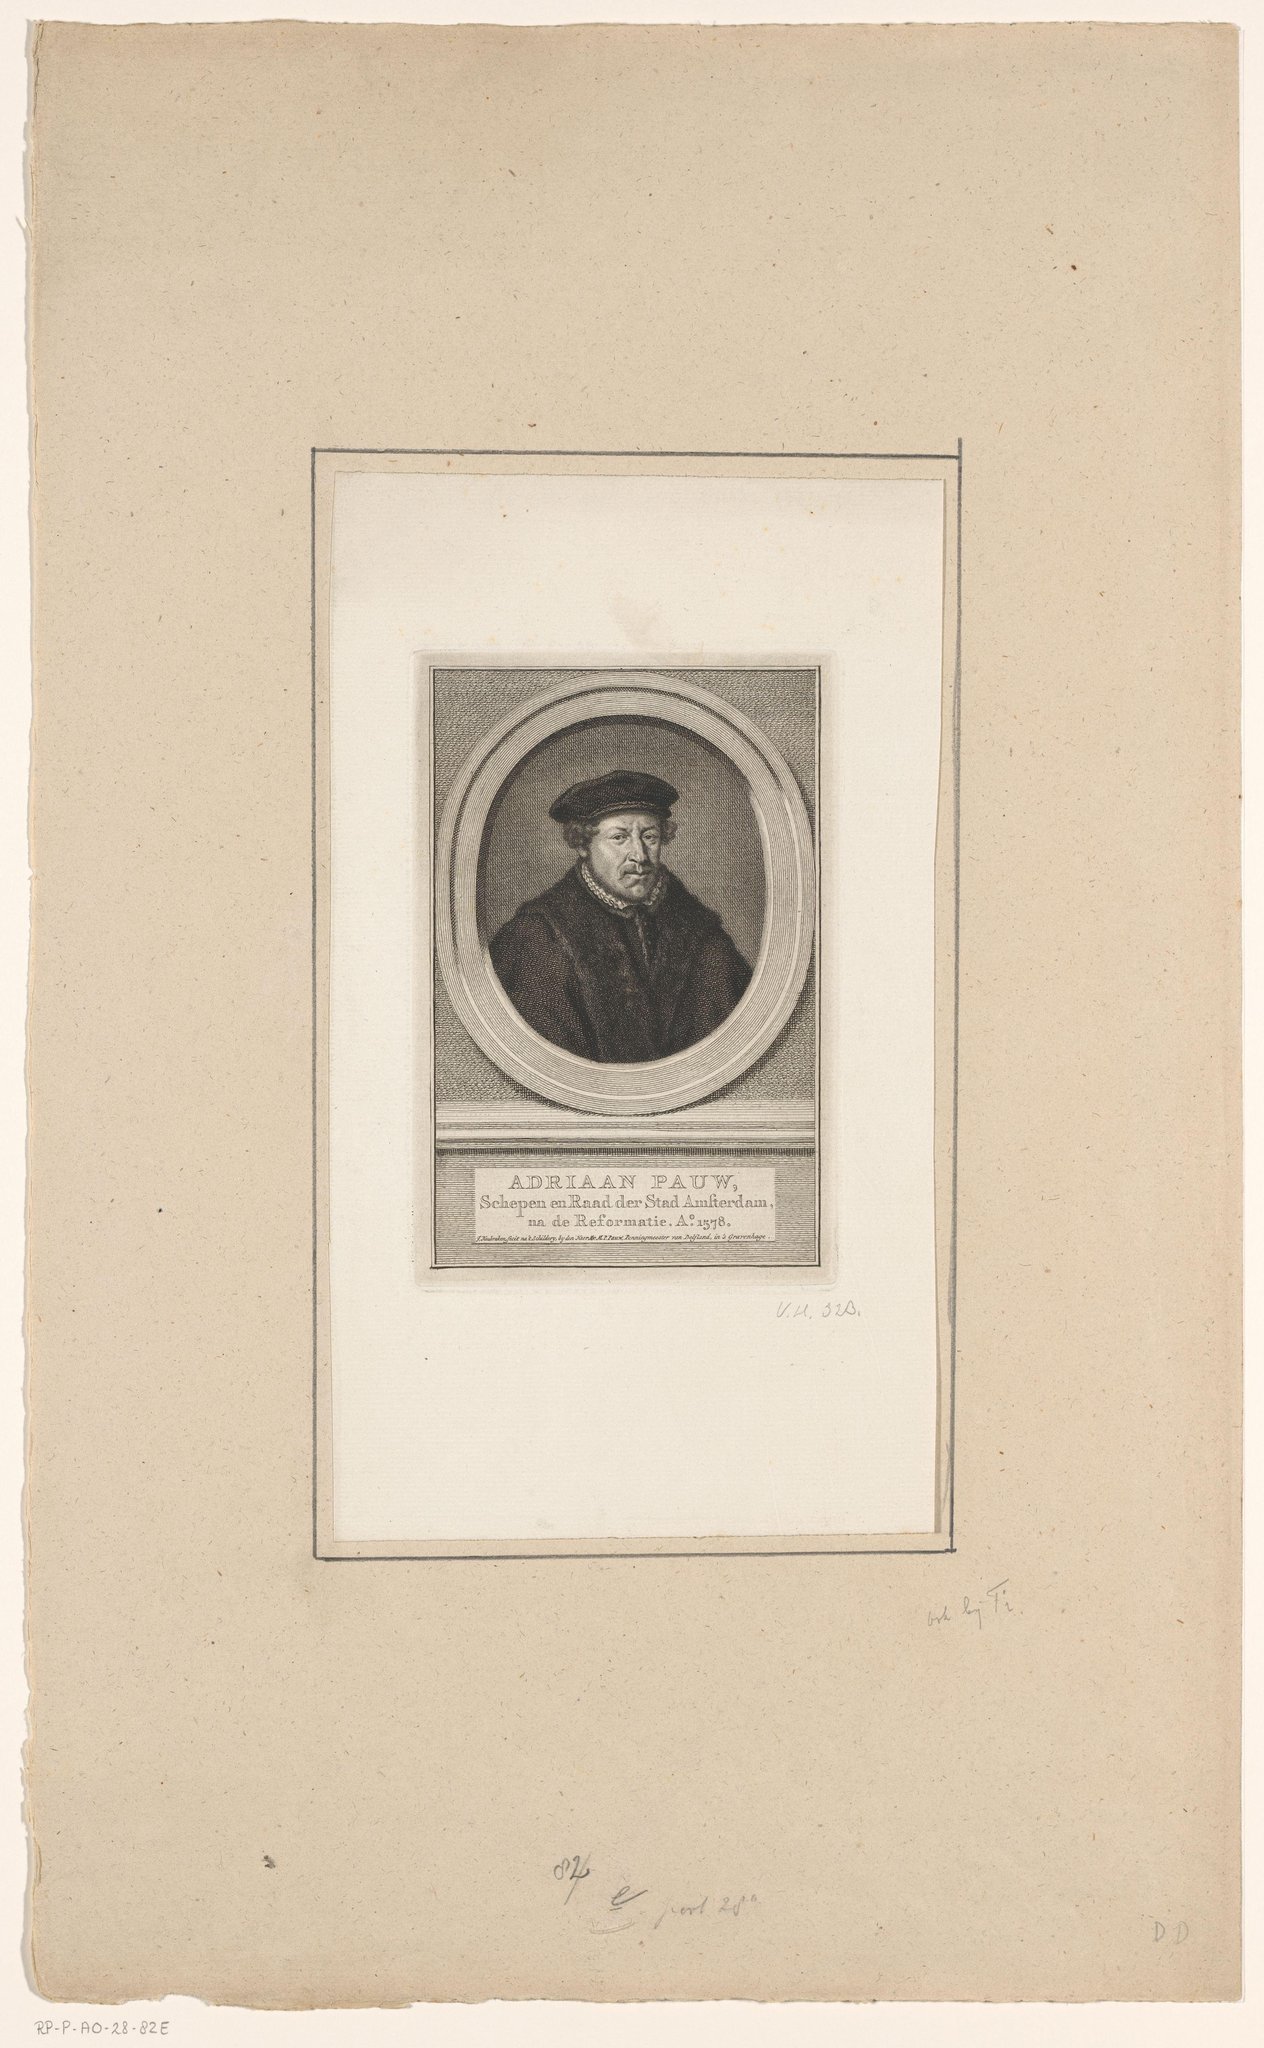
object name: print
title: Portret van Adriaan Pauw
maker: jacob houbraken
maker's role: draughtsman, print maker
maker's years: 1698-1780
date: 1749-1780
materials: paper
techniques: engraving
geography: amsterdam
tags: historical persons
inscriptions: collector's mark: Lugt 2228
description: Deze prent is oorspronkelijk bedoeld als aanvulling op Jan Wagenaars ‘Vaderlandsche historie’* en was zo vanaf 1796 verkrijgbaar bij Johannes Allart te Amsterdam. Voor de advertentie waarin Allart de 60 portretten en 7 platen, allen gegraveerd door Houbraken, ter aanvulling op Wagenaars ‘Vaderlandsche historie’ aanbiedt, zie RP-P-OB-77.766. *Van dit werk zijn in de achttiende eeuw meerdere uitgaves verschenen, zoals: Wagenaar, Jan. Vaderlandsche historie, vervattende de geschiedenissen der Vereenigde Nederlanden (…). 21 delen. Amsterdam: Isaak Tirion, 1749-1759. Wagenaar, Jan. Vaderlandsche historie, vervattende de geschiedenissen der nu Vereenigde Nederlanden (…). 21 delen. Amsterdam: weduwe Isaak Tirion, 1770. Wagenaar, Jan. Vaderlandsche historie, vervattende de geschiedenissen der nu Vereenigde Nederlanden (…). 21 delen. Amsterdam, Leiden, Dordrecht en Harlingen: P. Schouten e.a., 1782. Wagenaar, Jan. Vaderlandsche historie, vervattende de geschiedenissen der nu Vereenigde Nederlanden (…). 21 delen. Amsterdam: Johannes Allart, 1790-1796.